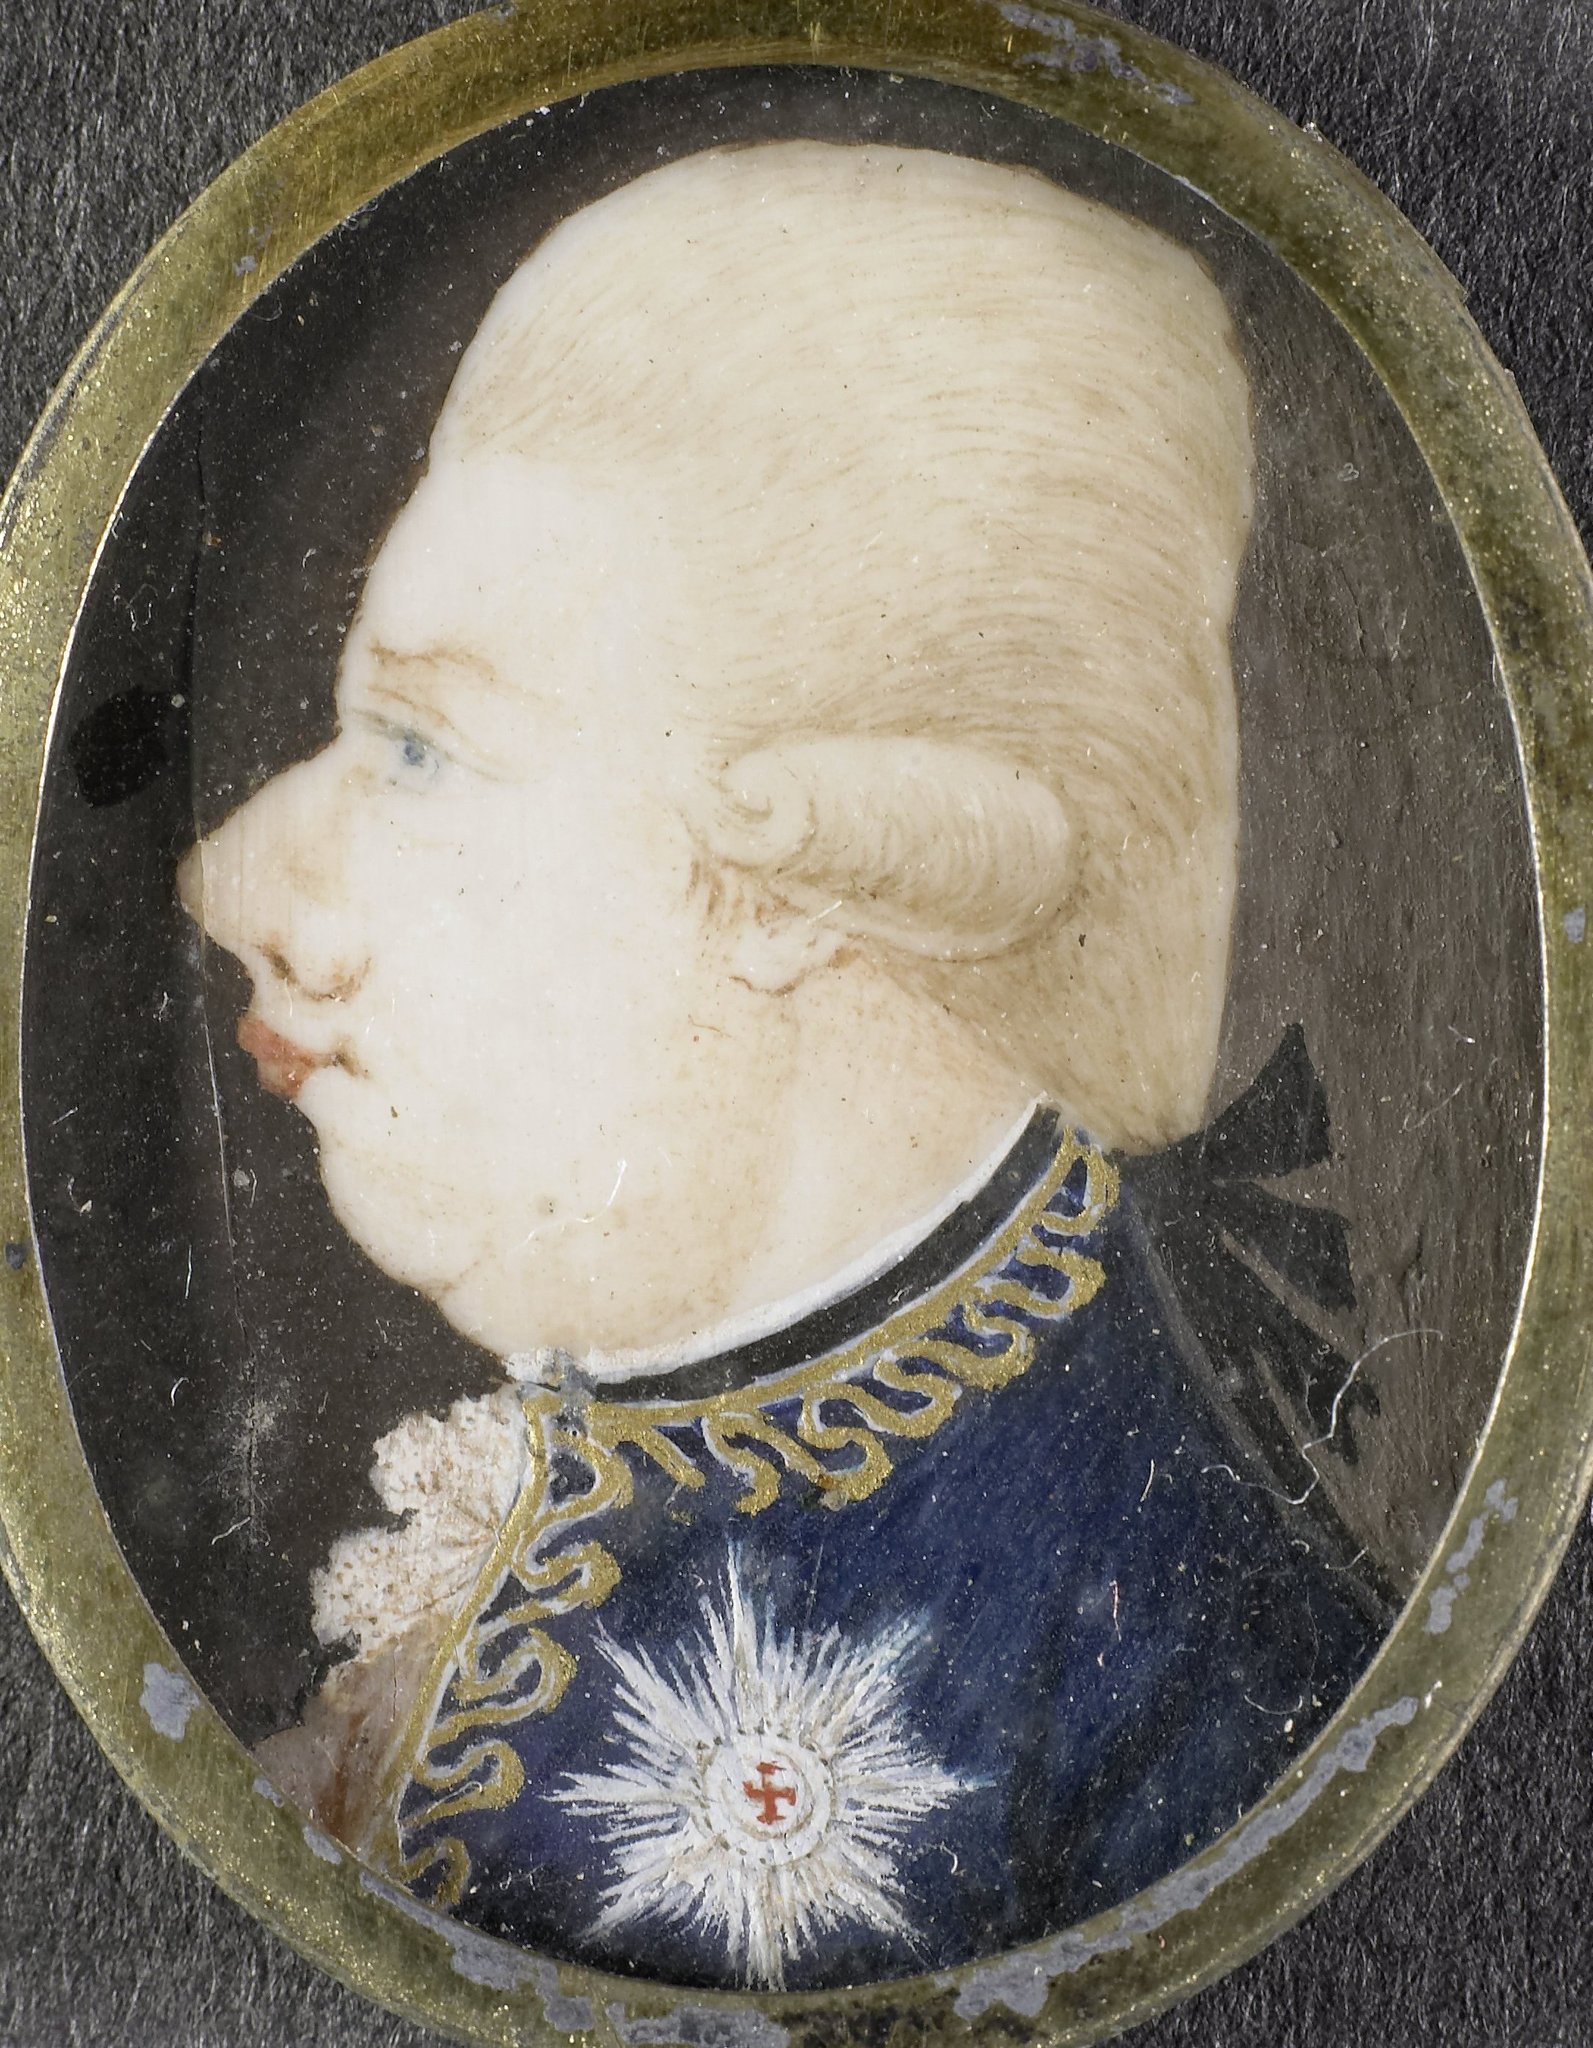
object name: painting, miniature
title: Willem V (1748-1806), prins van Oranje-Nassau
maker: Anonymous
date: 1780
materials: glass, ivory, metal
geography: netherlands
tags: william v (prince of orange), historical persons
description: Portret van Willem V (1748-1806), prins van Oranje-Nassau. Buste, in profiel naar links. Onderdeel van de collectie portretminiaturen.